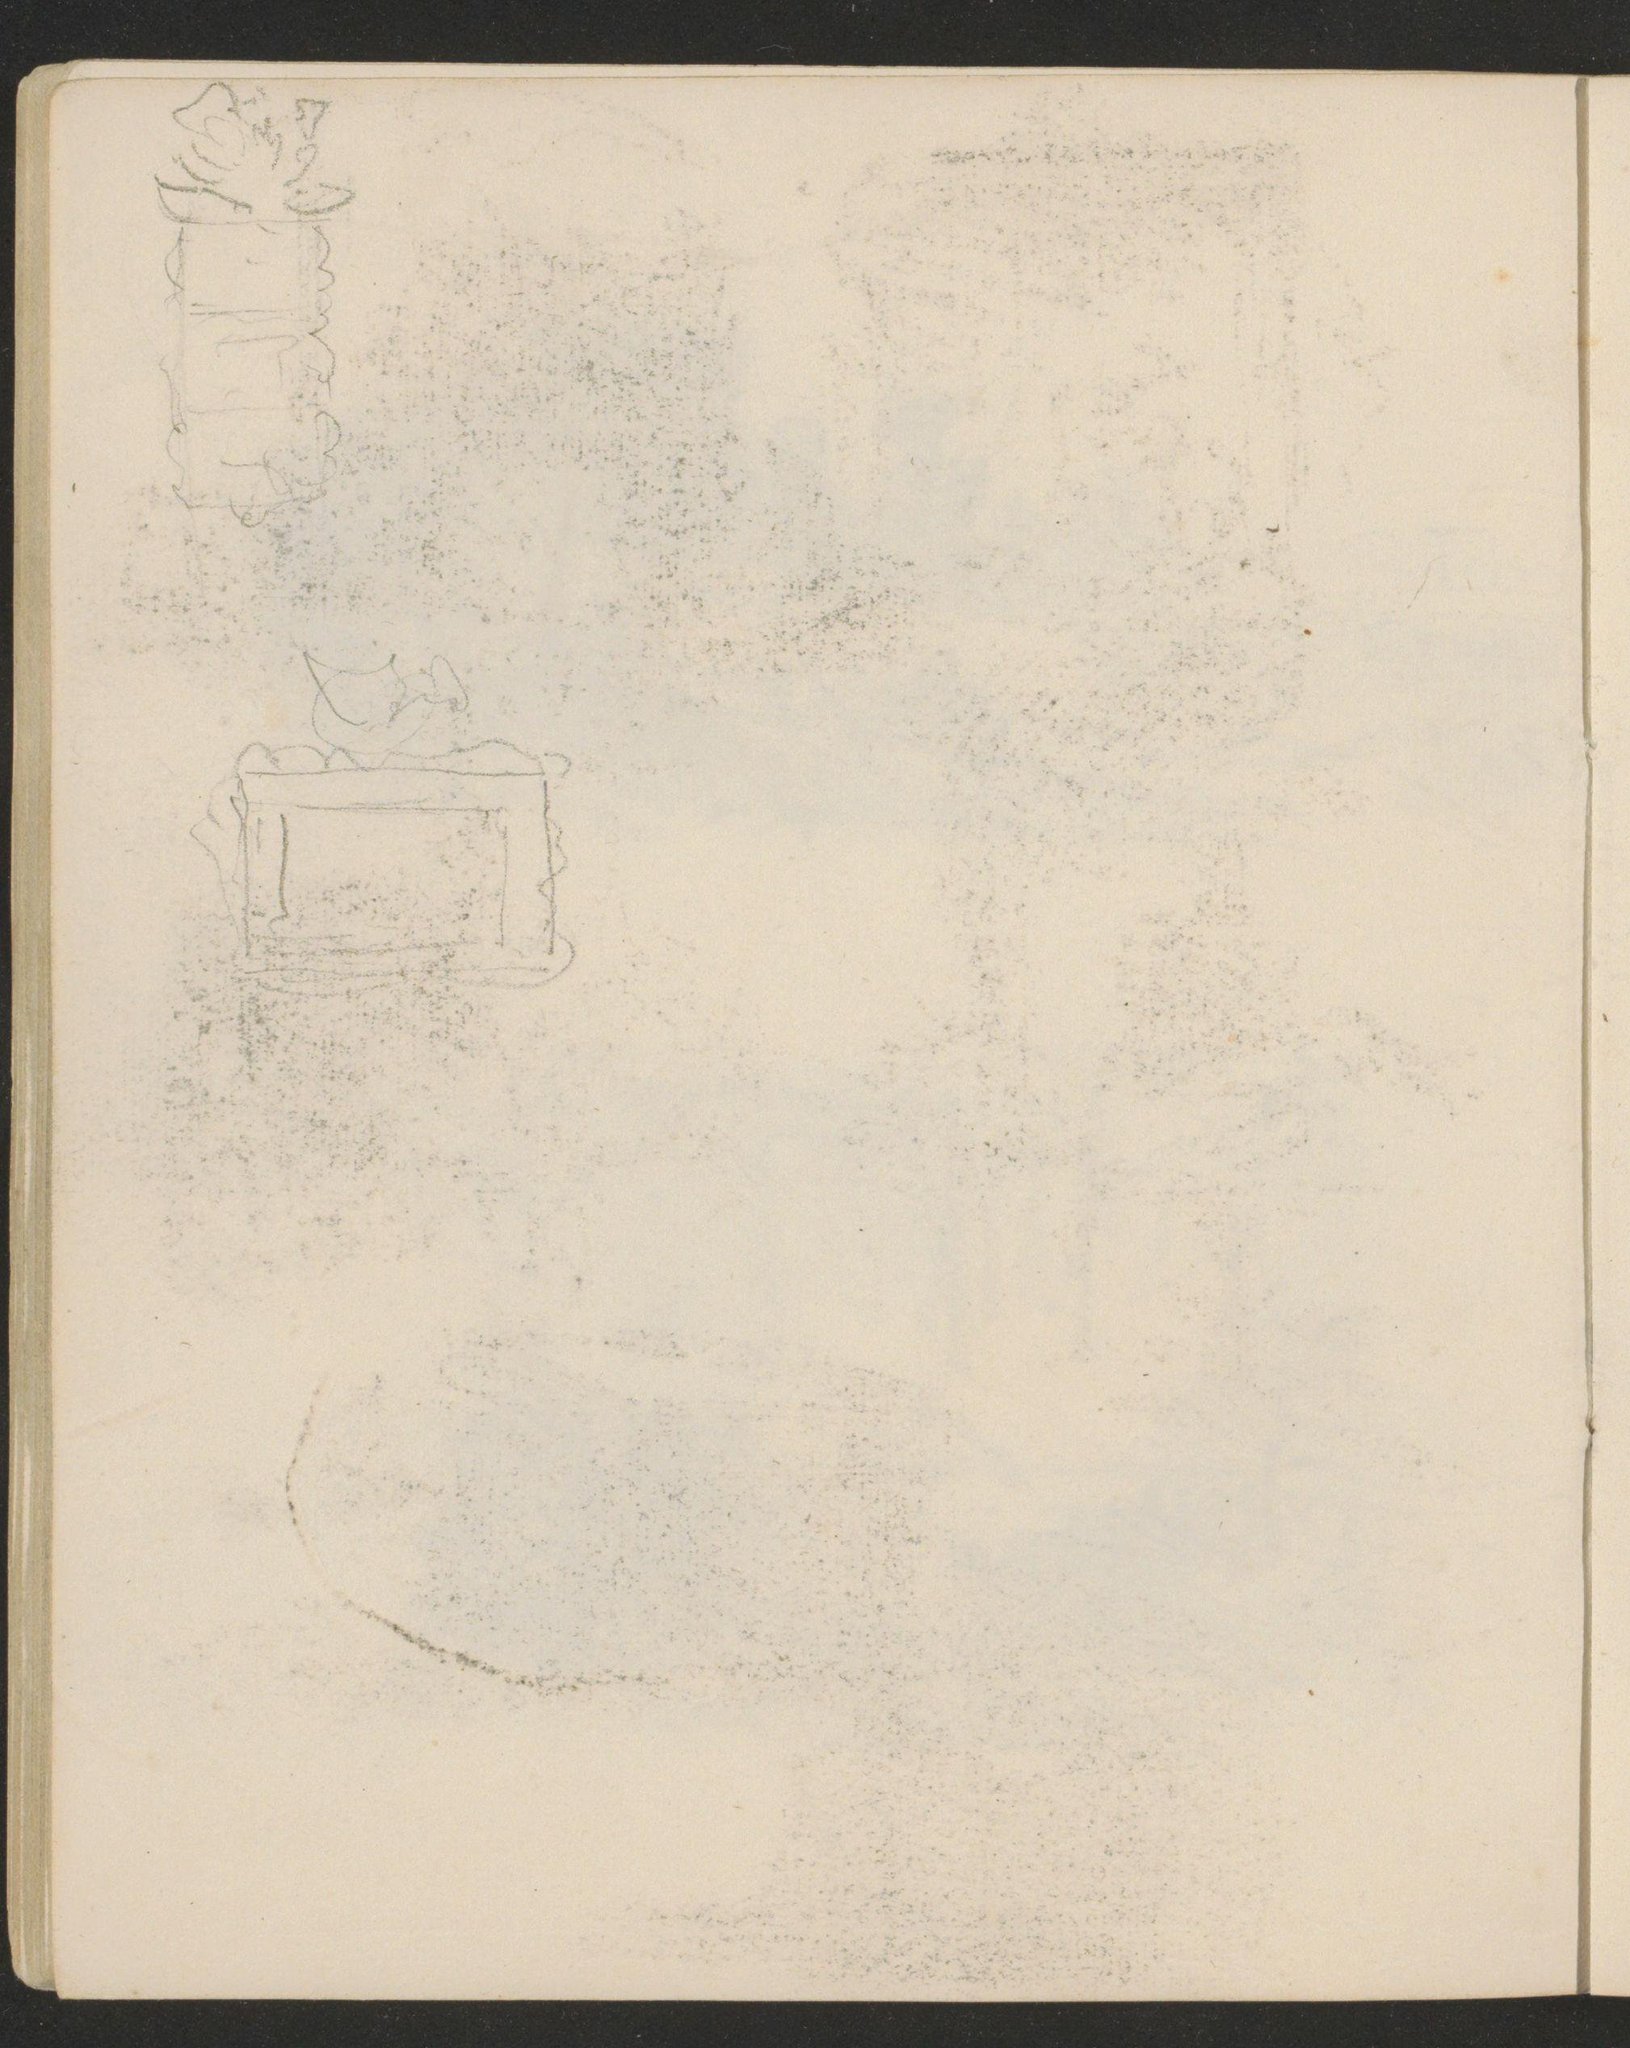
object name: sketchbook leaf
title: Lijst en een ornament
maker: maria vos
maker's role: draughtsman, painter, print maker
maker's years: 1824-1906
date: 1858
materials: paper, pencil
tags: frame of painting, etc.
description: Blad 9 verso uit een schetsboek met 19 bladen.